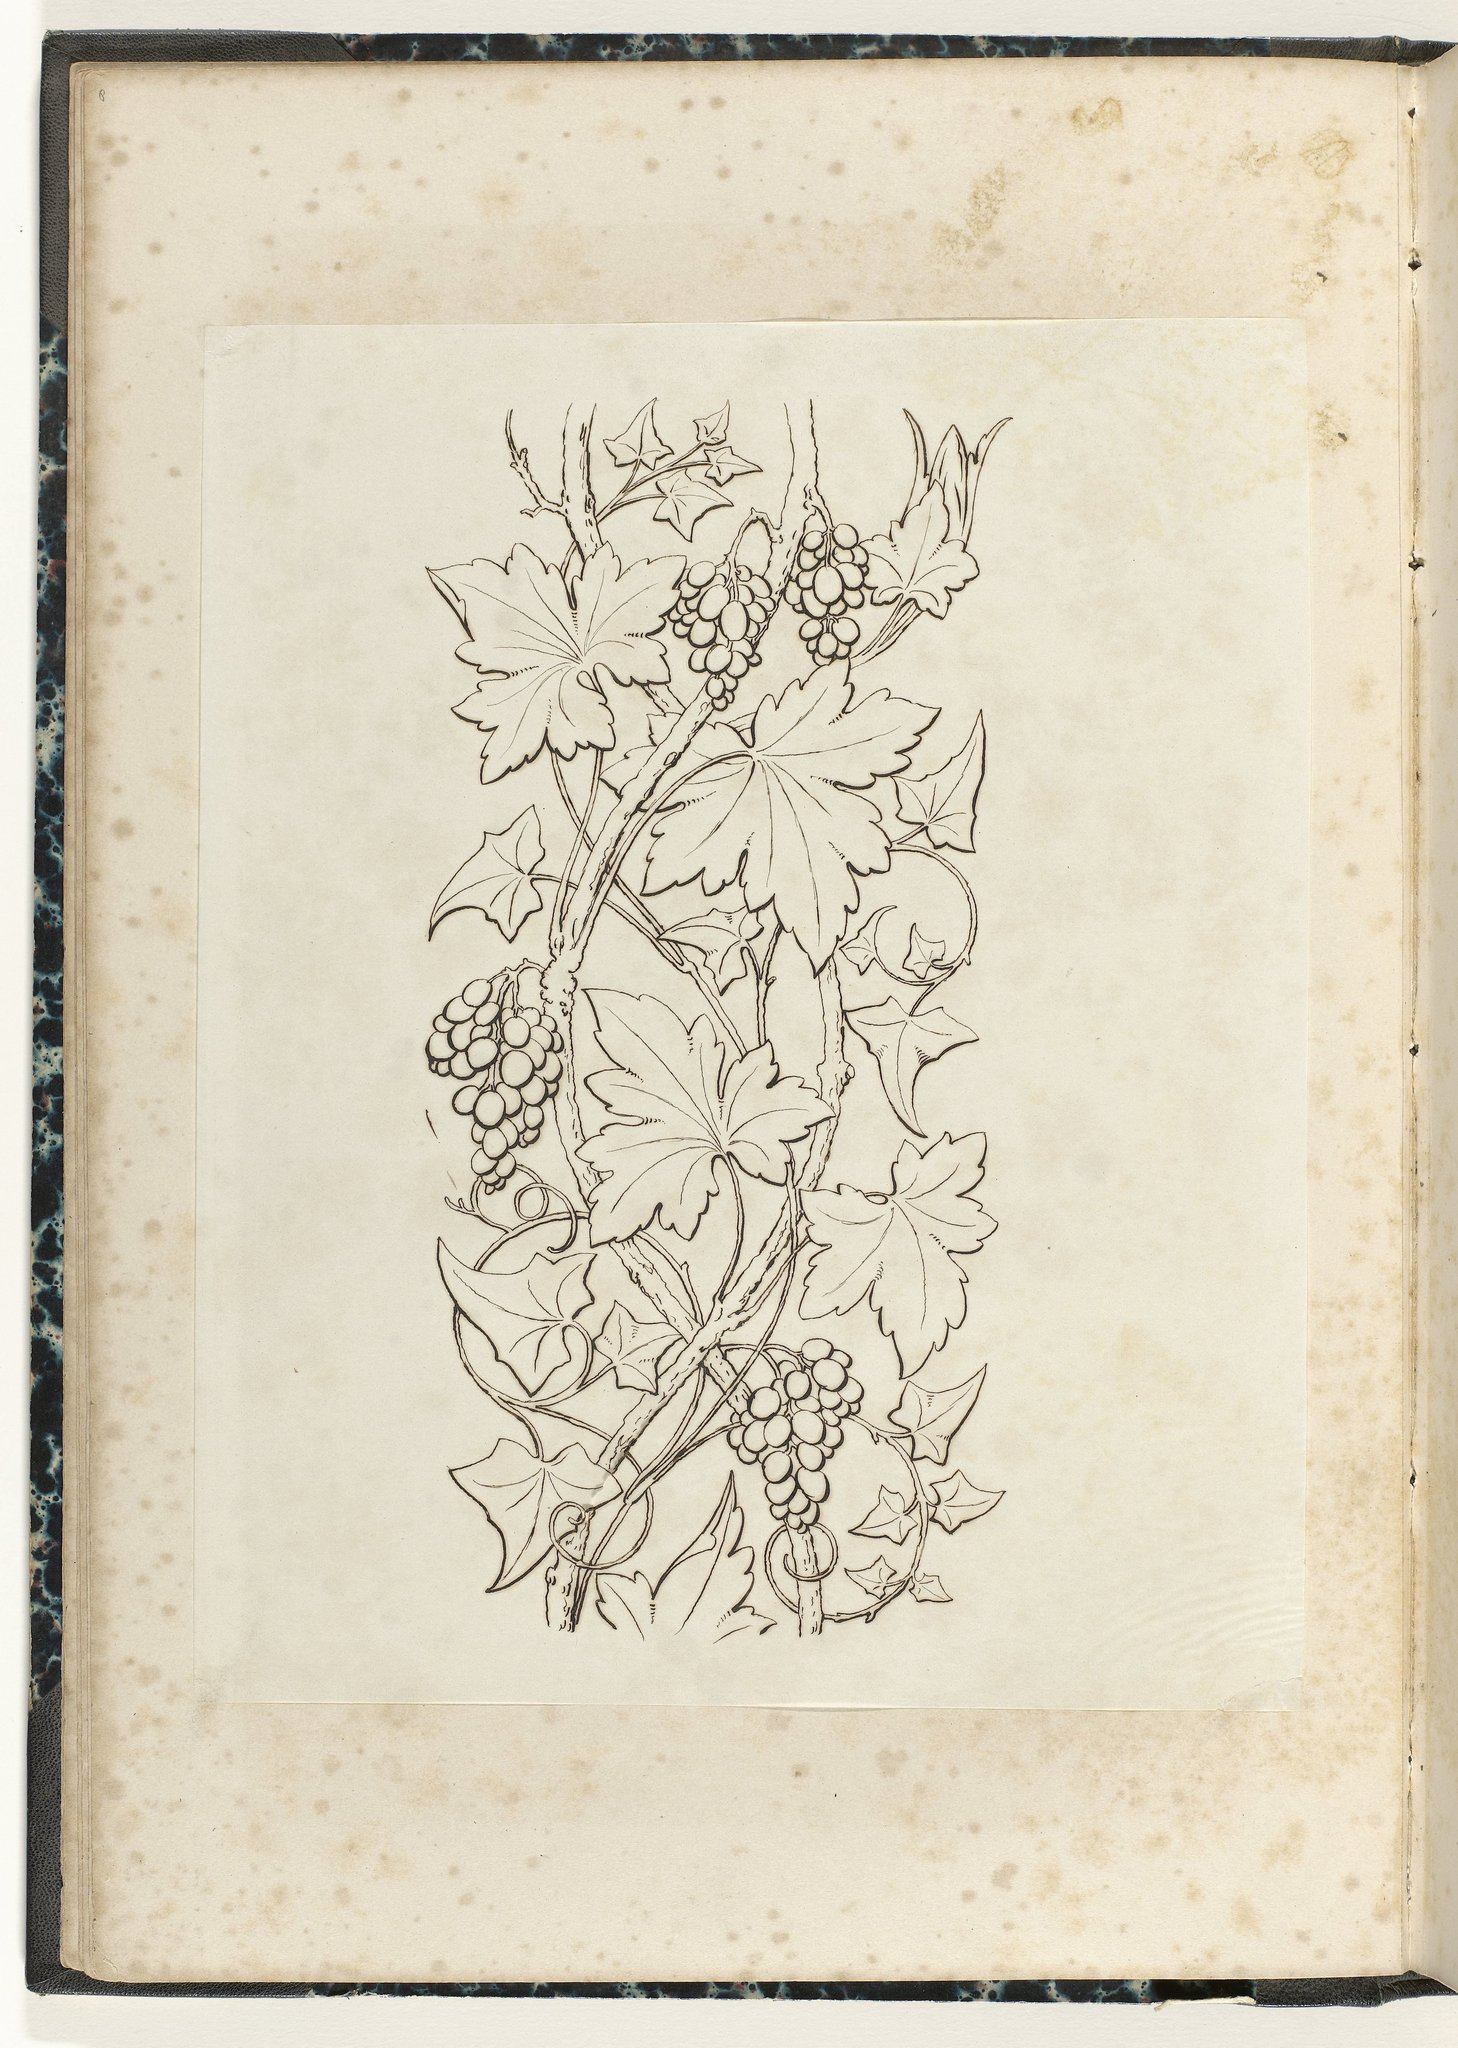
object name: drawing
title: Wijnranken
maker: Anonymous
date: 1866-1900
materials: ink, paper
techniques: drawing